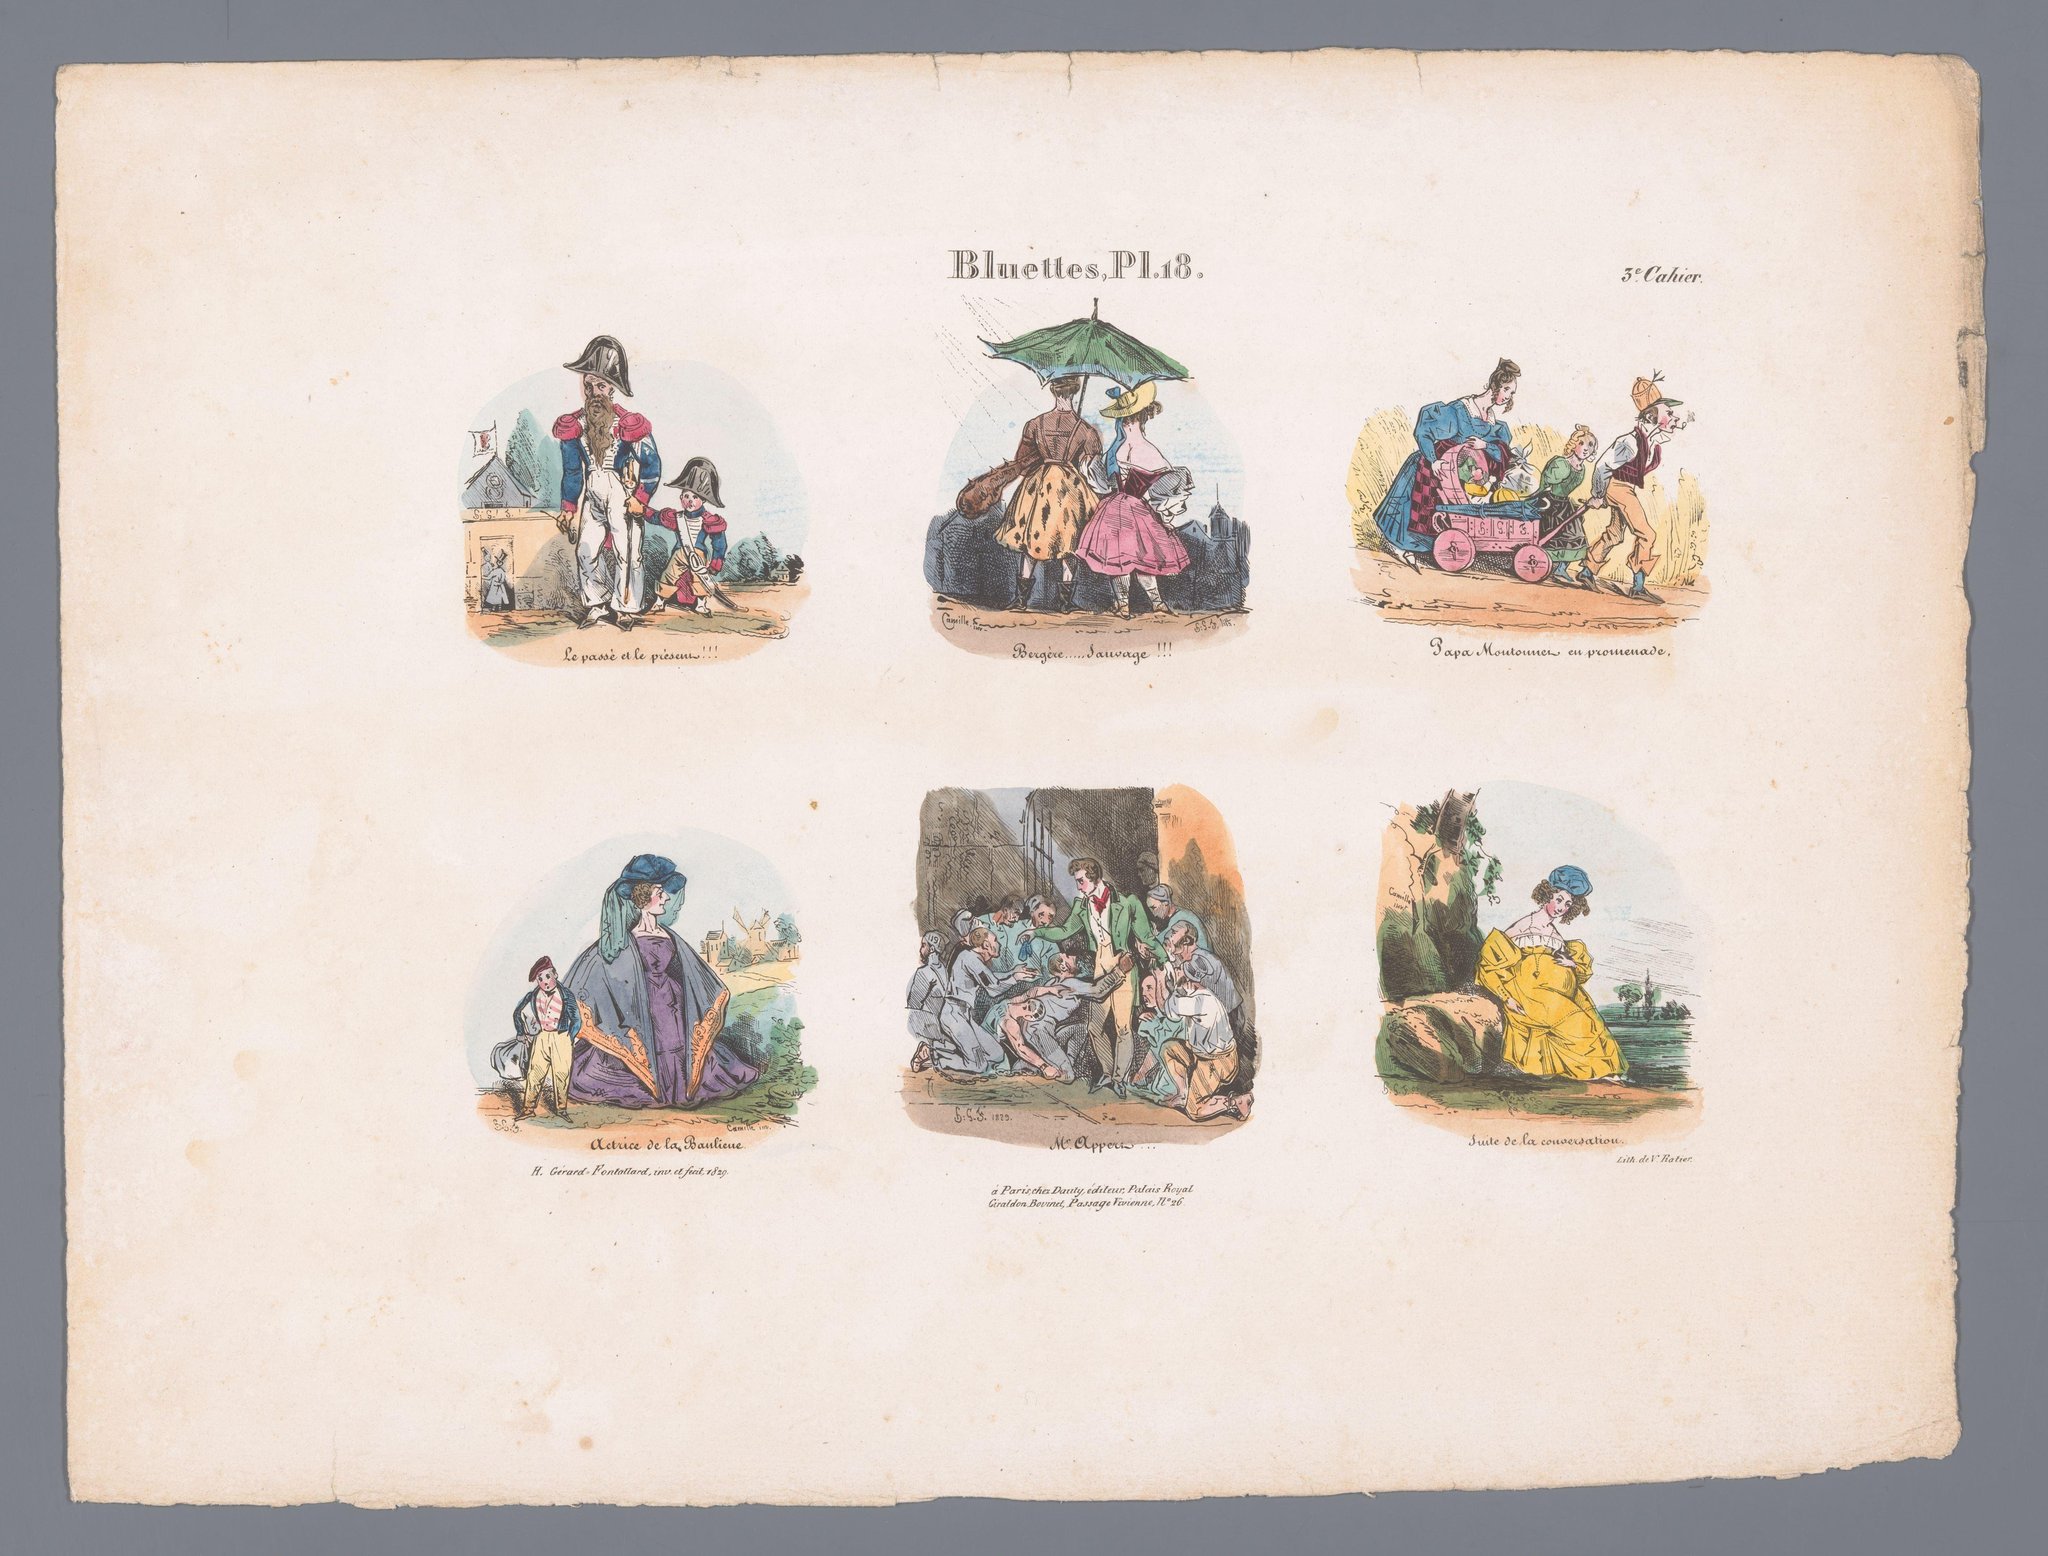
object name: print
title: Kleine scènes uit het dagelijks leven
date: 1829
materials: paper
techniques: hand coloring, lithograph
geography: paris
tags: various human types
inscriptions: collector's mark: Lugt 2228a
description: Prent maakt deel uit van een omslag met achttien prenten.